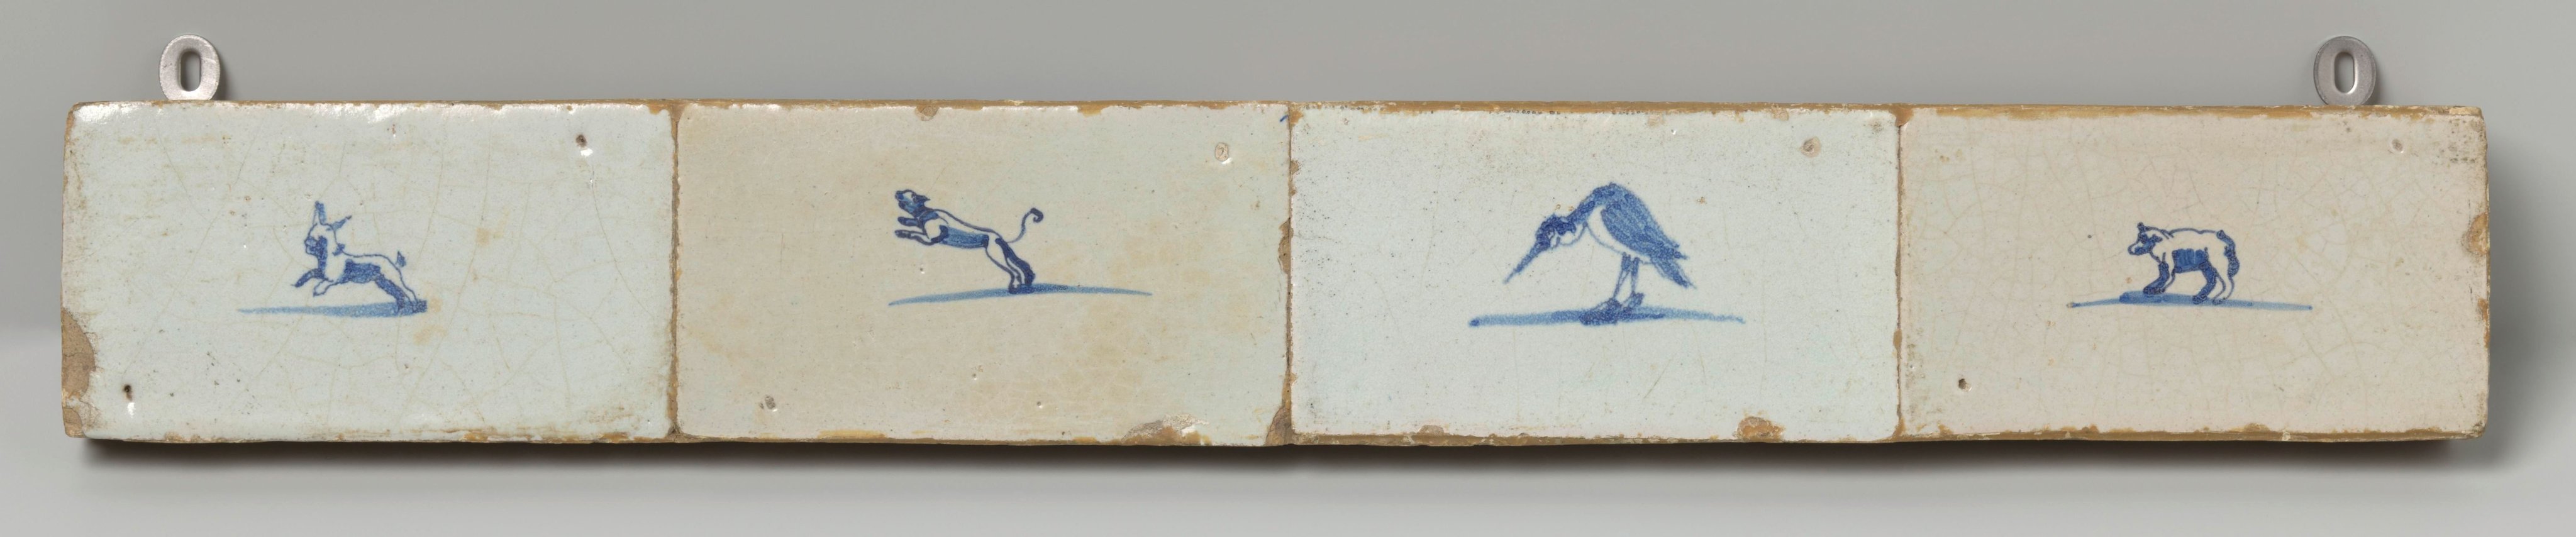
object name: randtegel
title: Veld van vier randtegels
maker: Anonymous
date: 1660-1700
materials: earthenware, glaze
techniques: maiolica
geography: netherlands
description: Veld van 4 randtegels (1 x 4) elk met een blauw geschilderd dier.